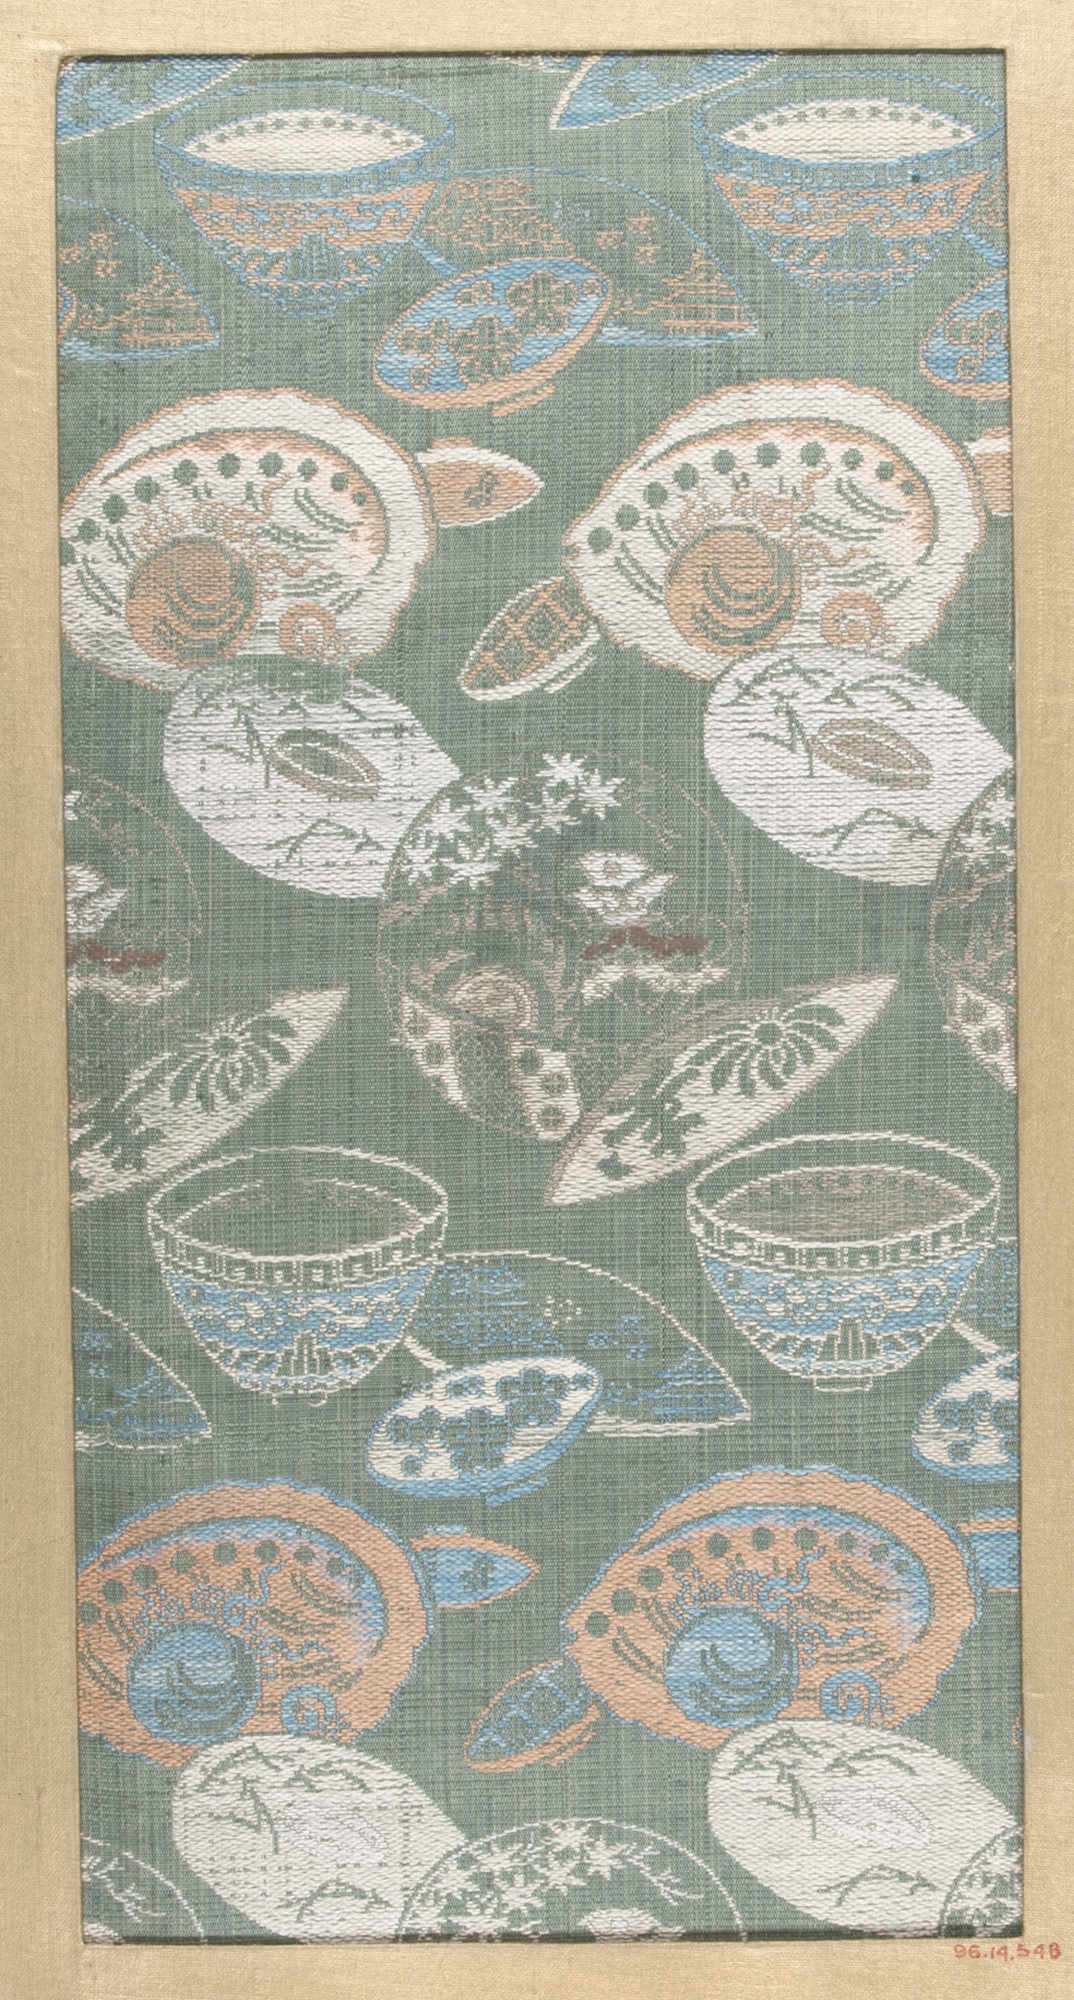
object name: piece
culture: japanese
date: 1701-1900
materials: silk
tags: bowls